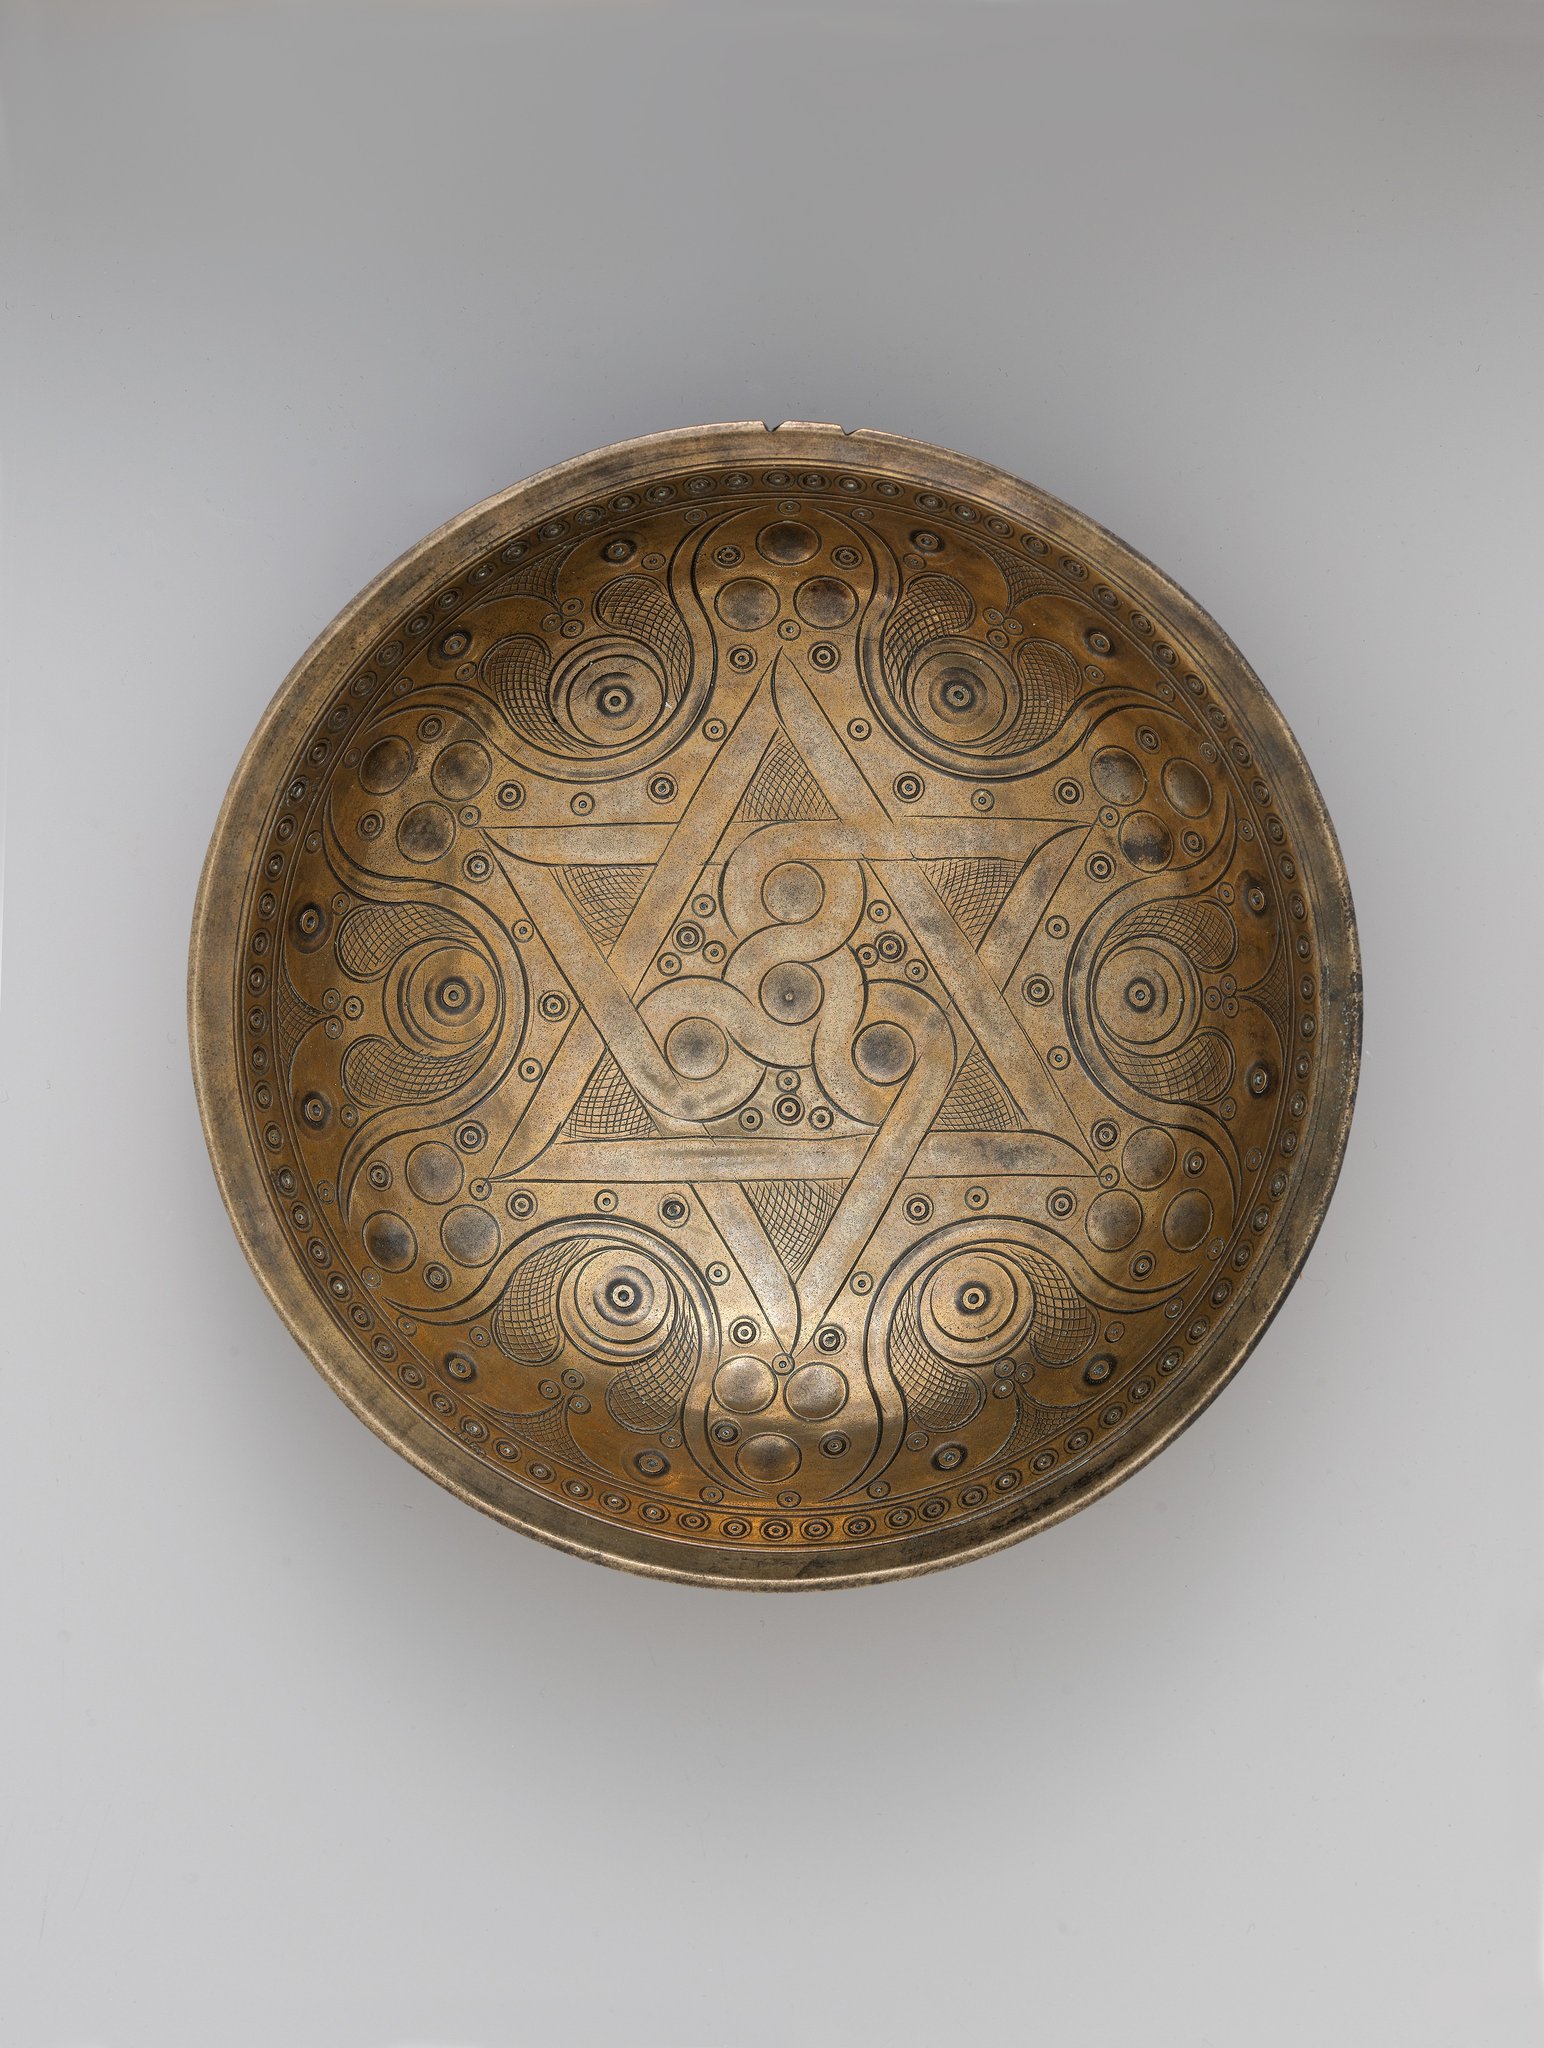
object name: bowl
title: High-Tin Bronze Bowl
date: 1101-1200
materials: bronze, tin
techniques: casting, chasing, engraving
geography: afghanistan